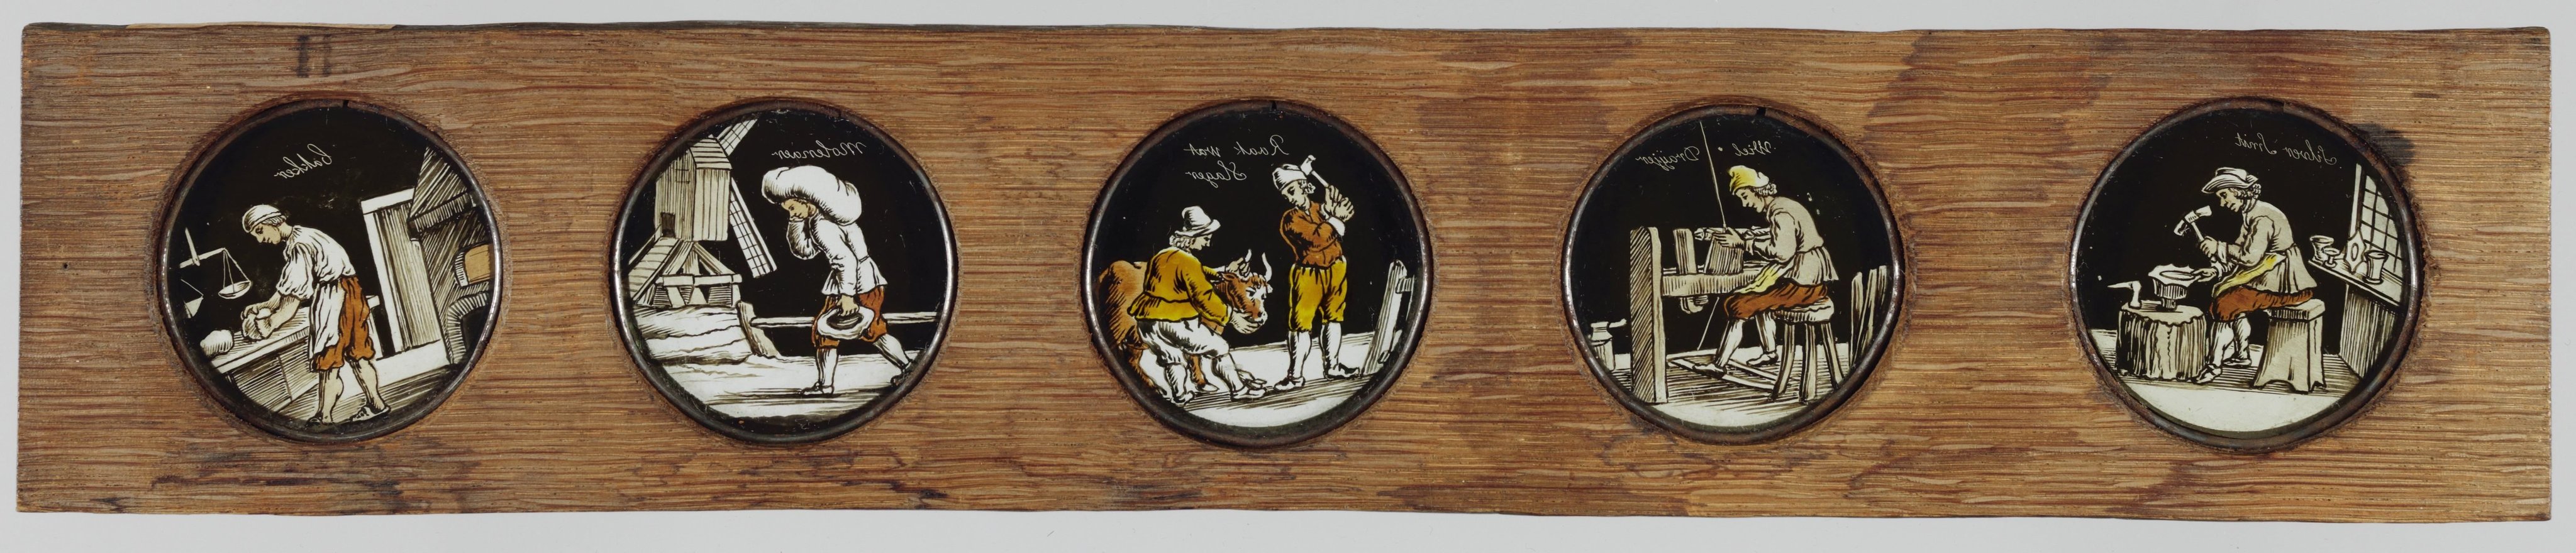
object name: lantern slide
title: Vijf beroepen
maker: Anonymous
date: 1700-1790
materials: glass, wood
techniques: painted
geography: netherlands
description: Vijf glaasjes met uitbeeldingen van beroepen in een houten vatting. Het uitgebeelde beroep wordt ook steeds op het glas vermeld. Uiterst links: 'silver smit', een zilversmid, zittend aan het werk bij een raam. Rechts daarvan: 'wiel draijjer', een man gezeten achter een houtdraaibank. In het midden: 'raak wat slager', een man brengt een koe aan terwijl een andere man klaarstaat met een hamer. Rechts daarvan 'molenaar', de molenaar tilt een zak met graan of meel, op de achtergrond een houten molen. Uiterst rechts: 'bakker', deze kneedt deeg aan een tafel waarboven een weegschaal hangt, links van hem een oven. Afbeeldingen lijken ten dele terug te gaan op de prenten het Menselyk Bedryf van Jan en Caspar Luyken, maar zijn hier niet direct van gekopieerd of overgetrokken. De uitgebeelde beroepen en de compositie van de afbeeldingen wijken hiervoor te zeer af van de oorspronkelijke prenten.